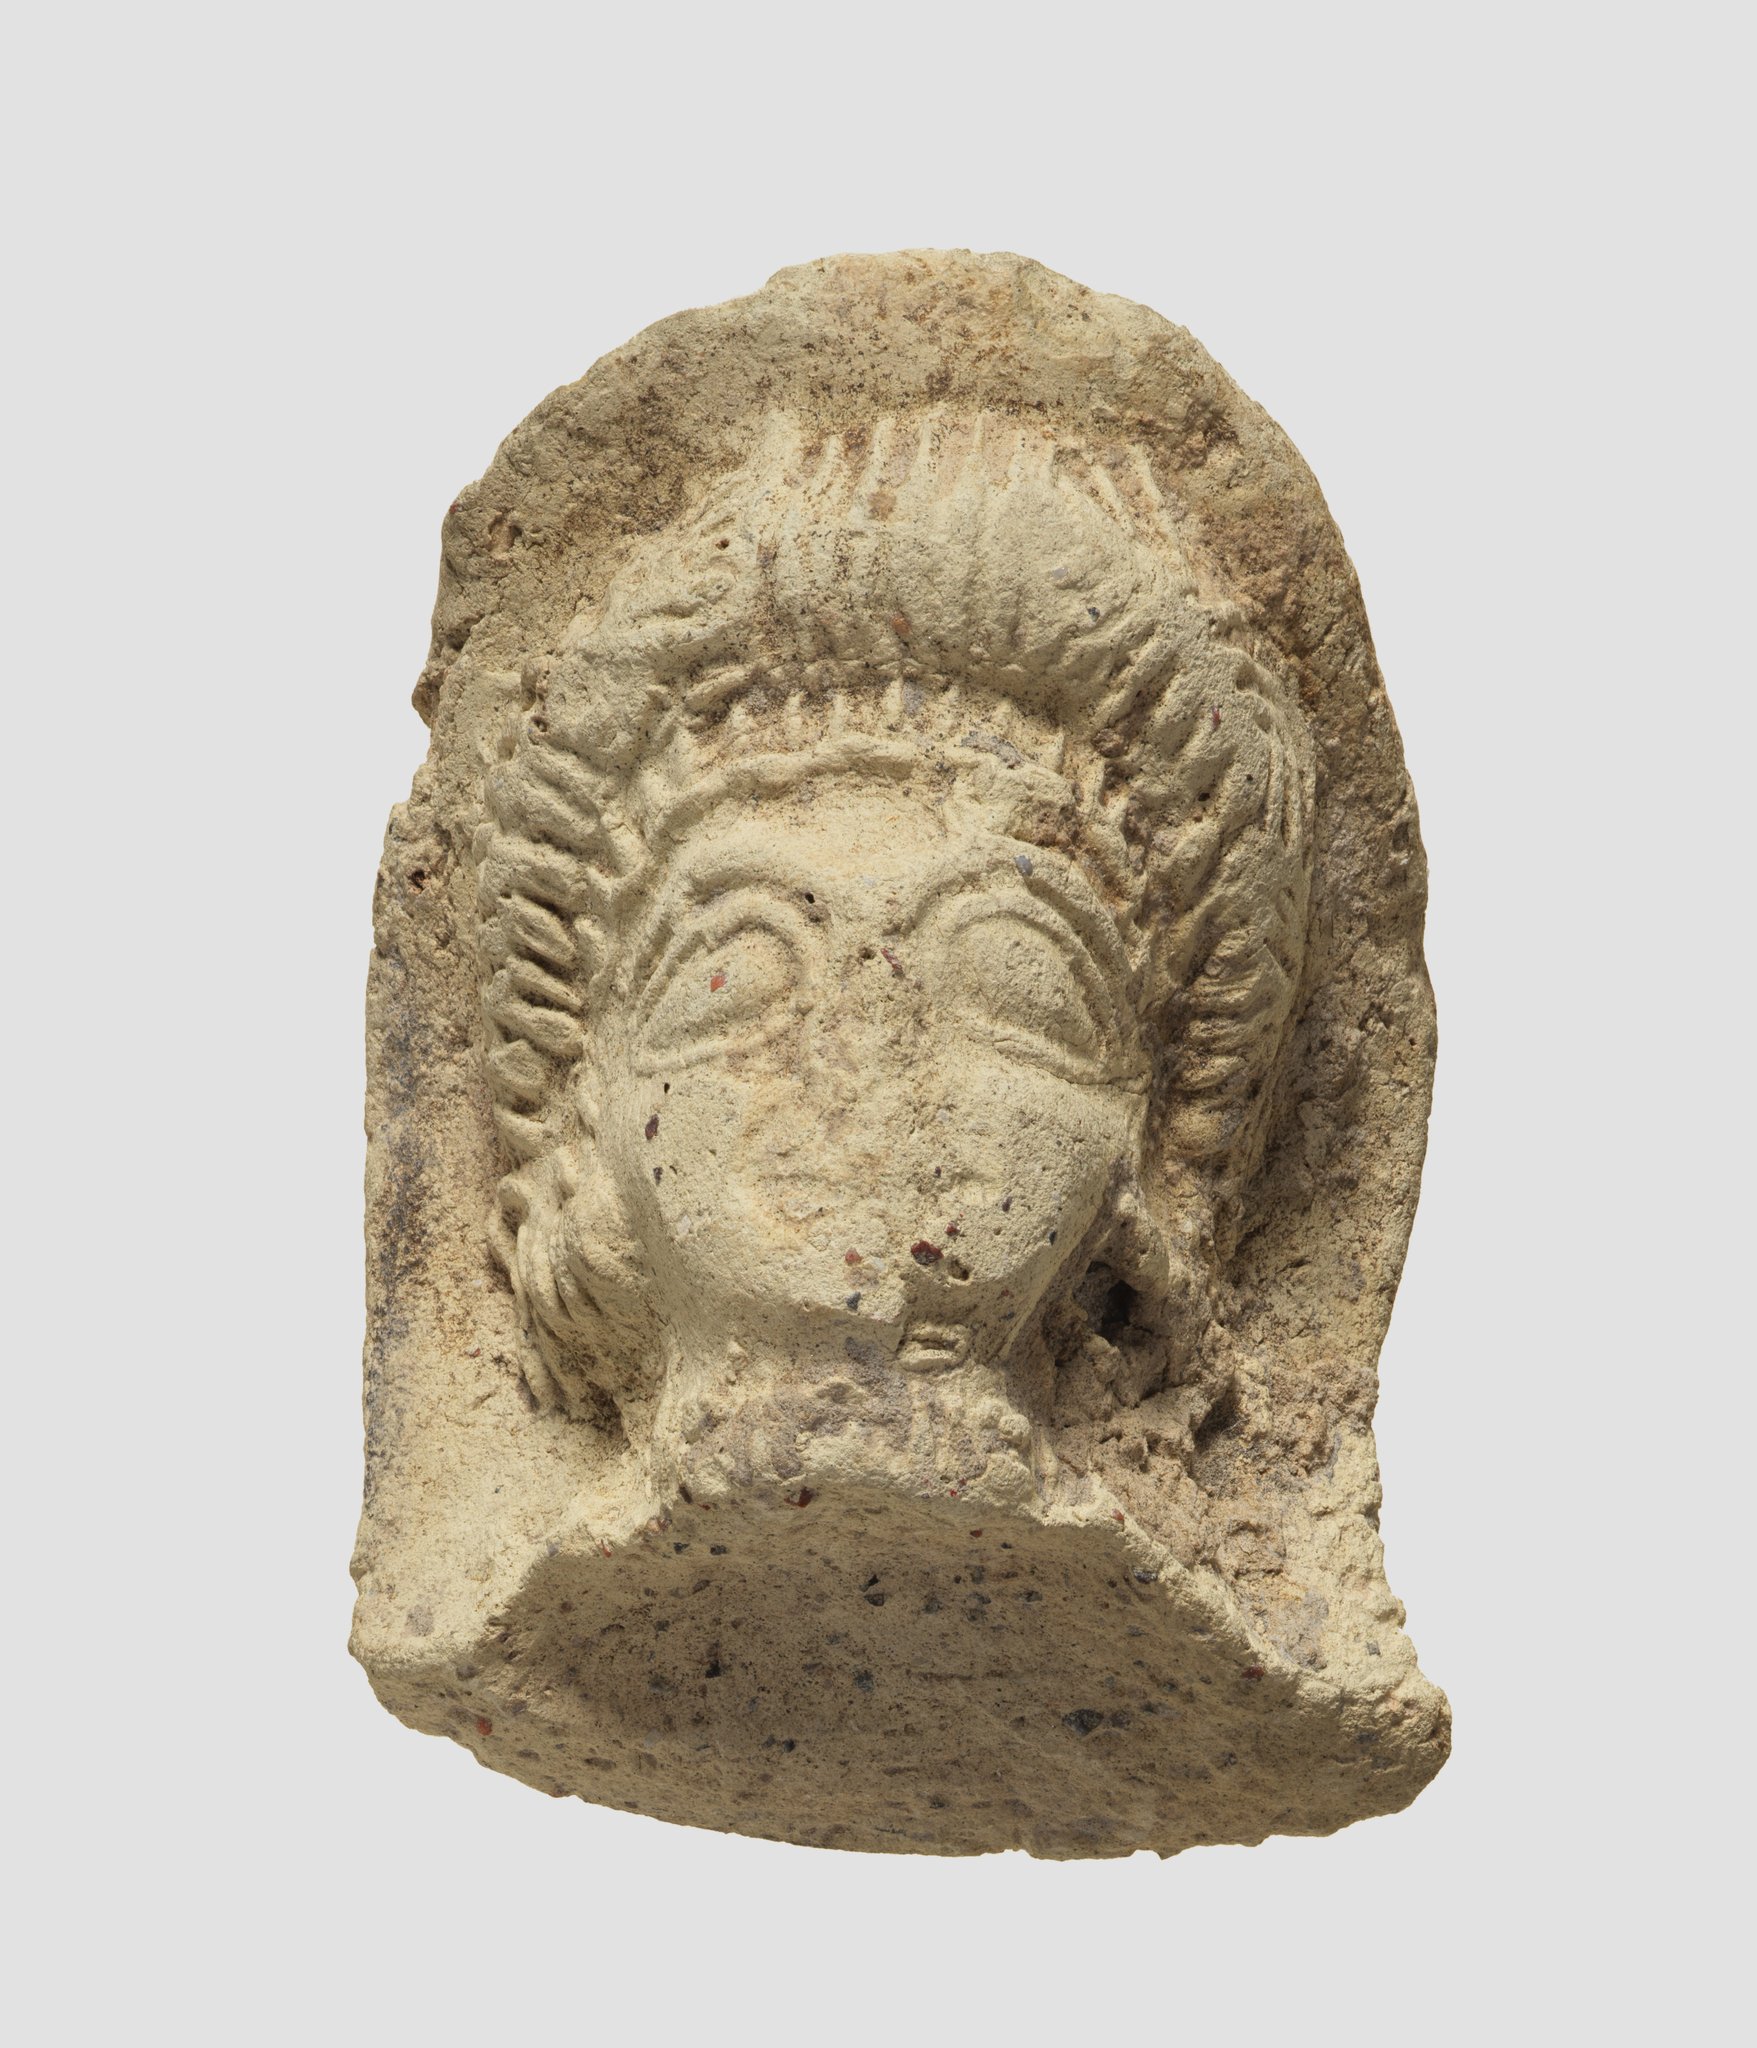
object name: sculpture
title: Figurine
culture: elamite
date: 1500-1100 BCE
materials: ceramic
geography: iran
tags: heads